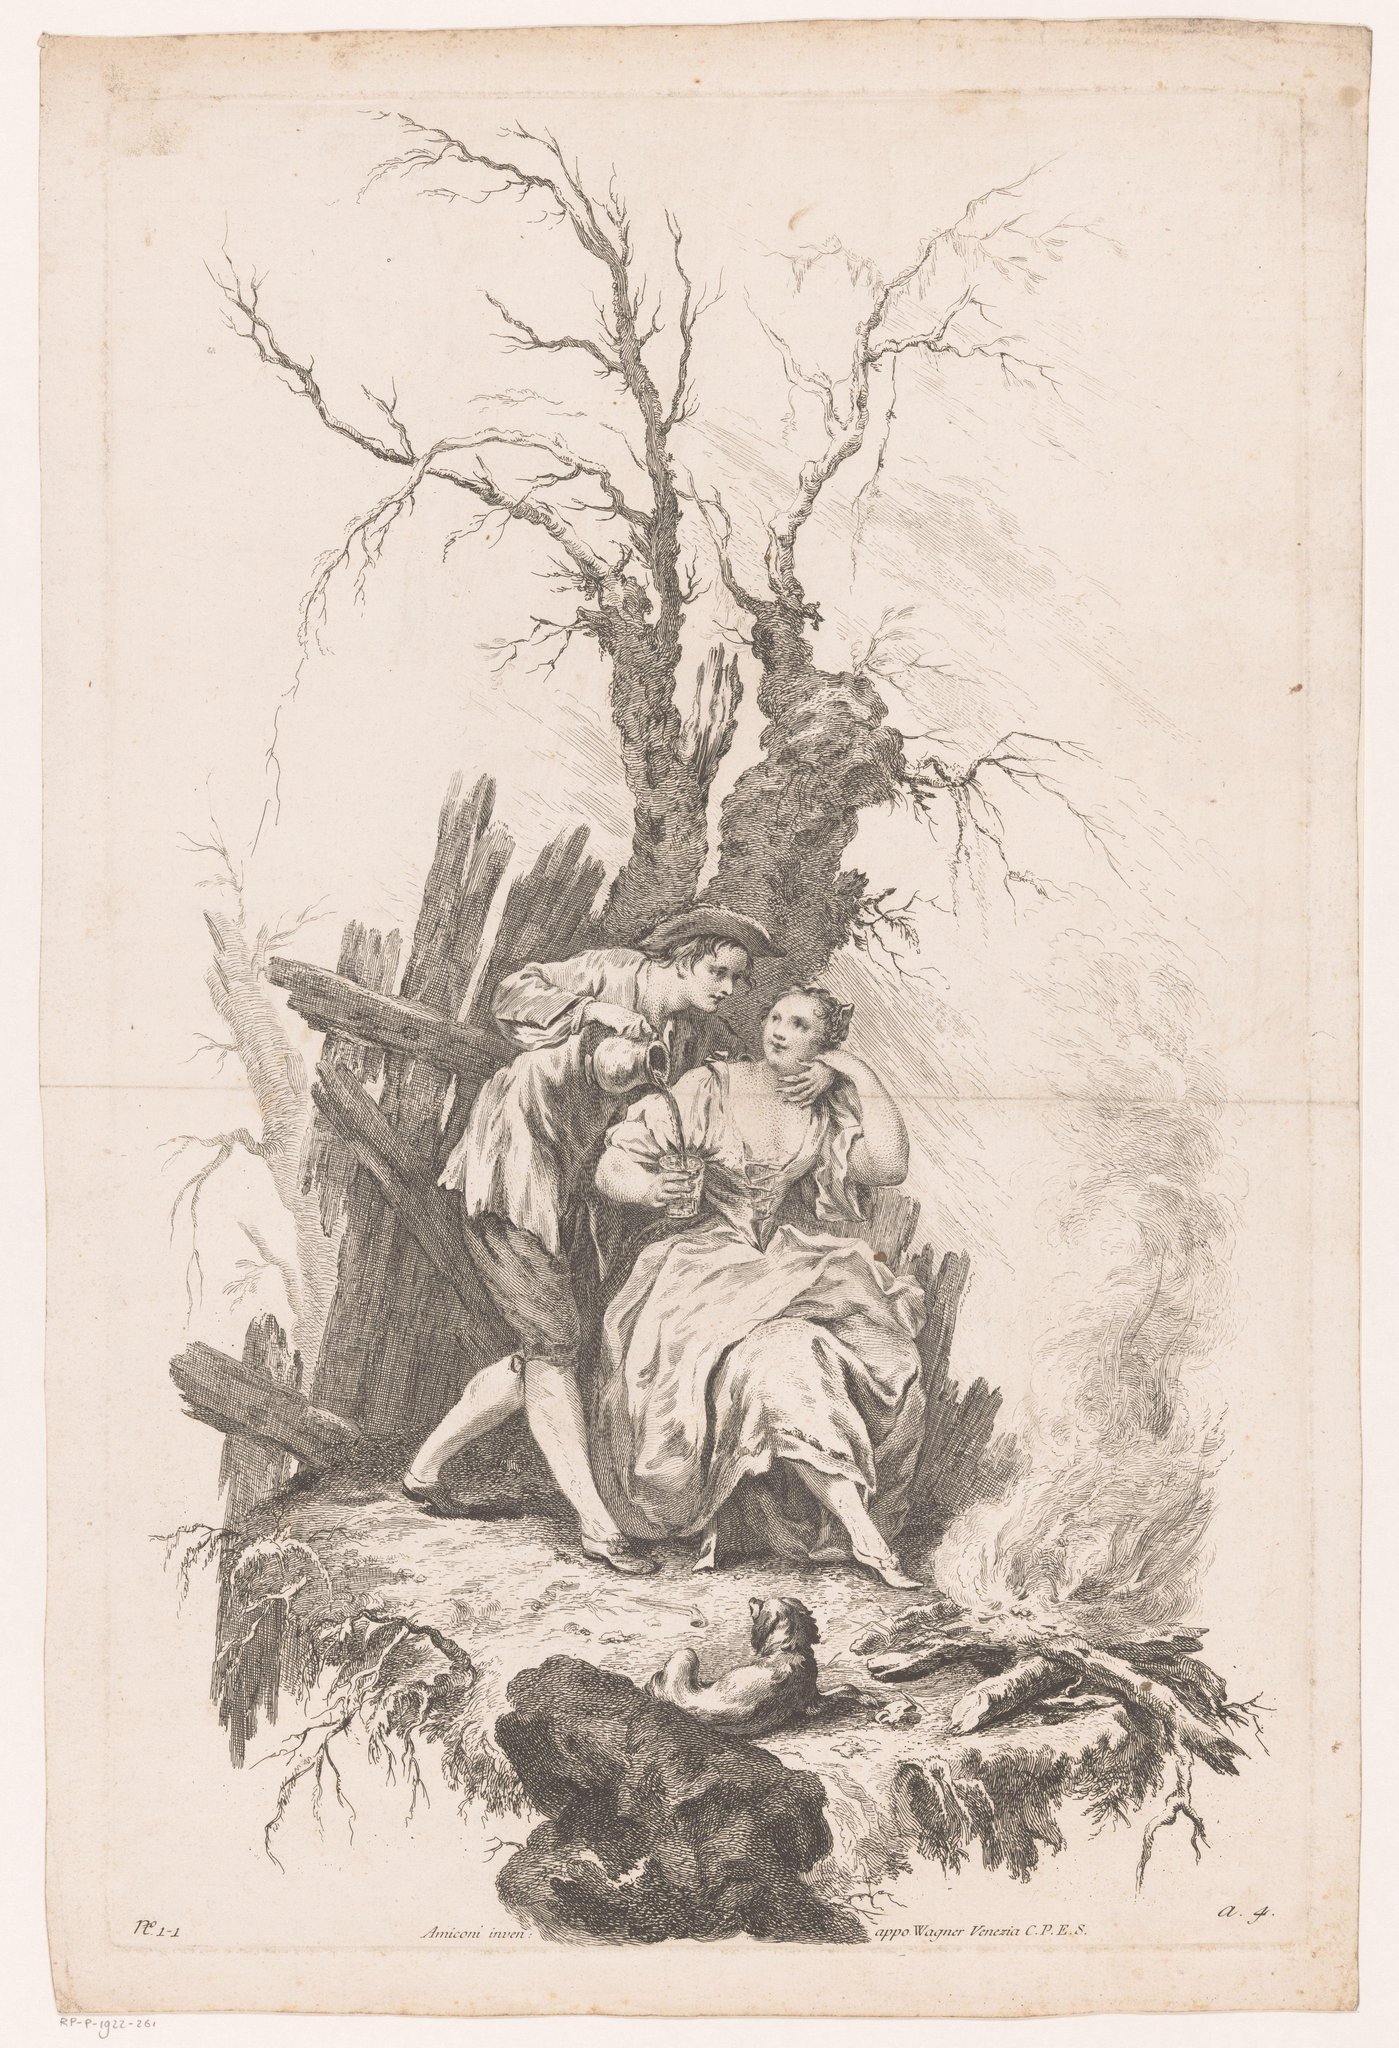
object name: print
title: Man en vrouw met hond bij een vuur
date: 1739-1780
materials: paper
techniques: engraving, etching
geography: venice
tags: pouring, pipe ~ tobacco, winter ~ human activities (the four seasons of the year), dog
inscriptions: collector's mark: Lugt 2233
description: Prent maakt deel uit van een serie bestaande uit vier genummerde prenten van de jaargetijden.